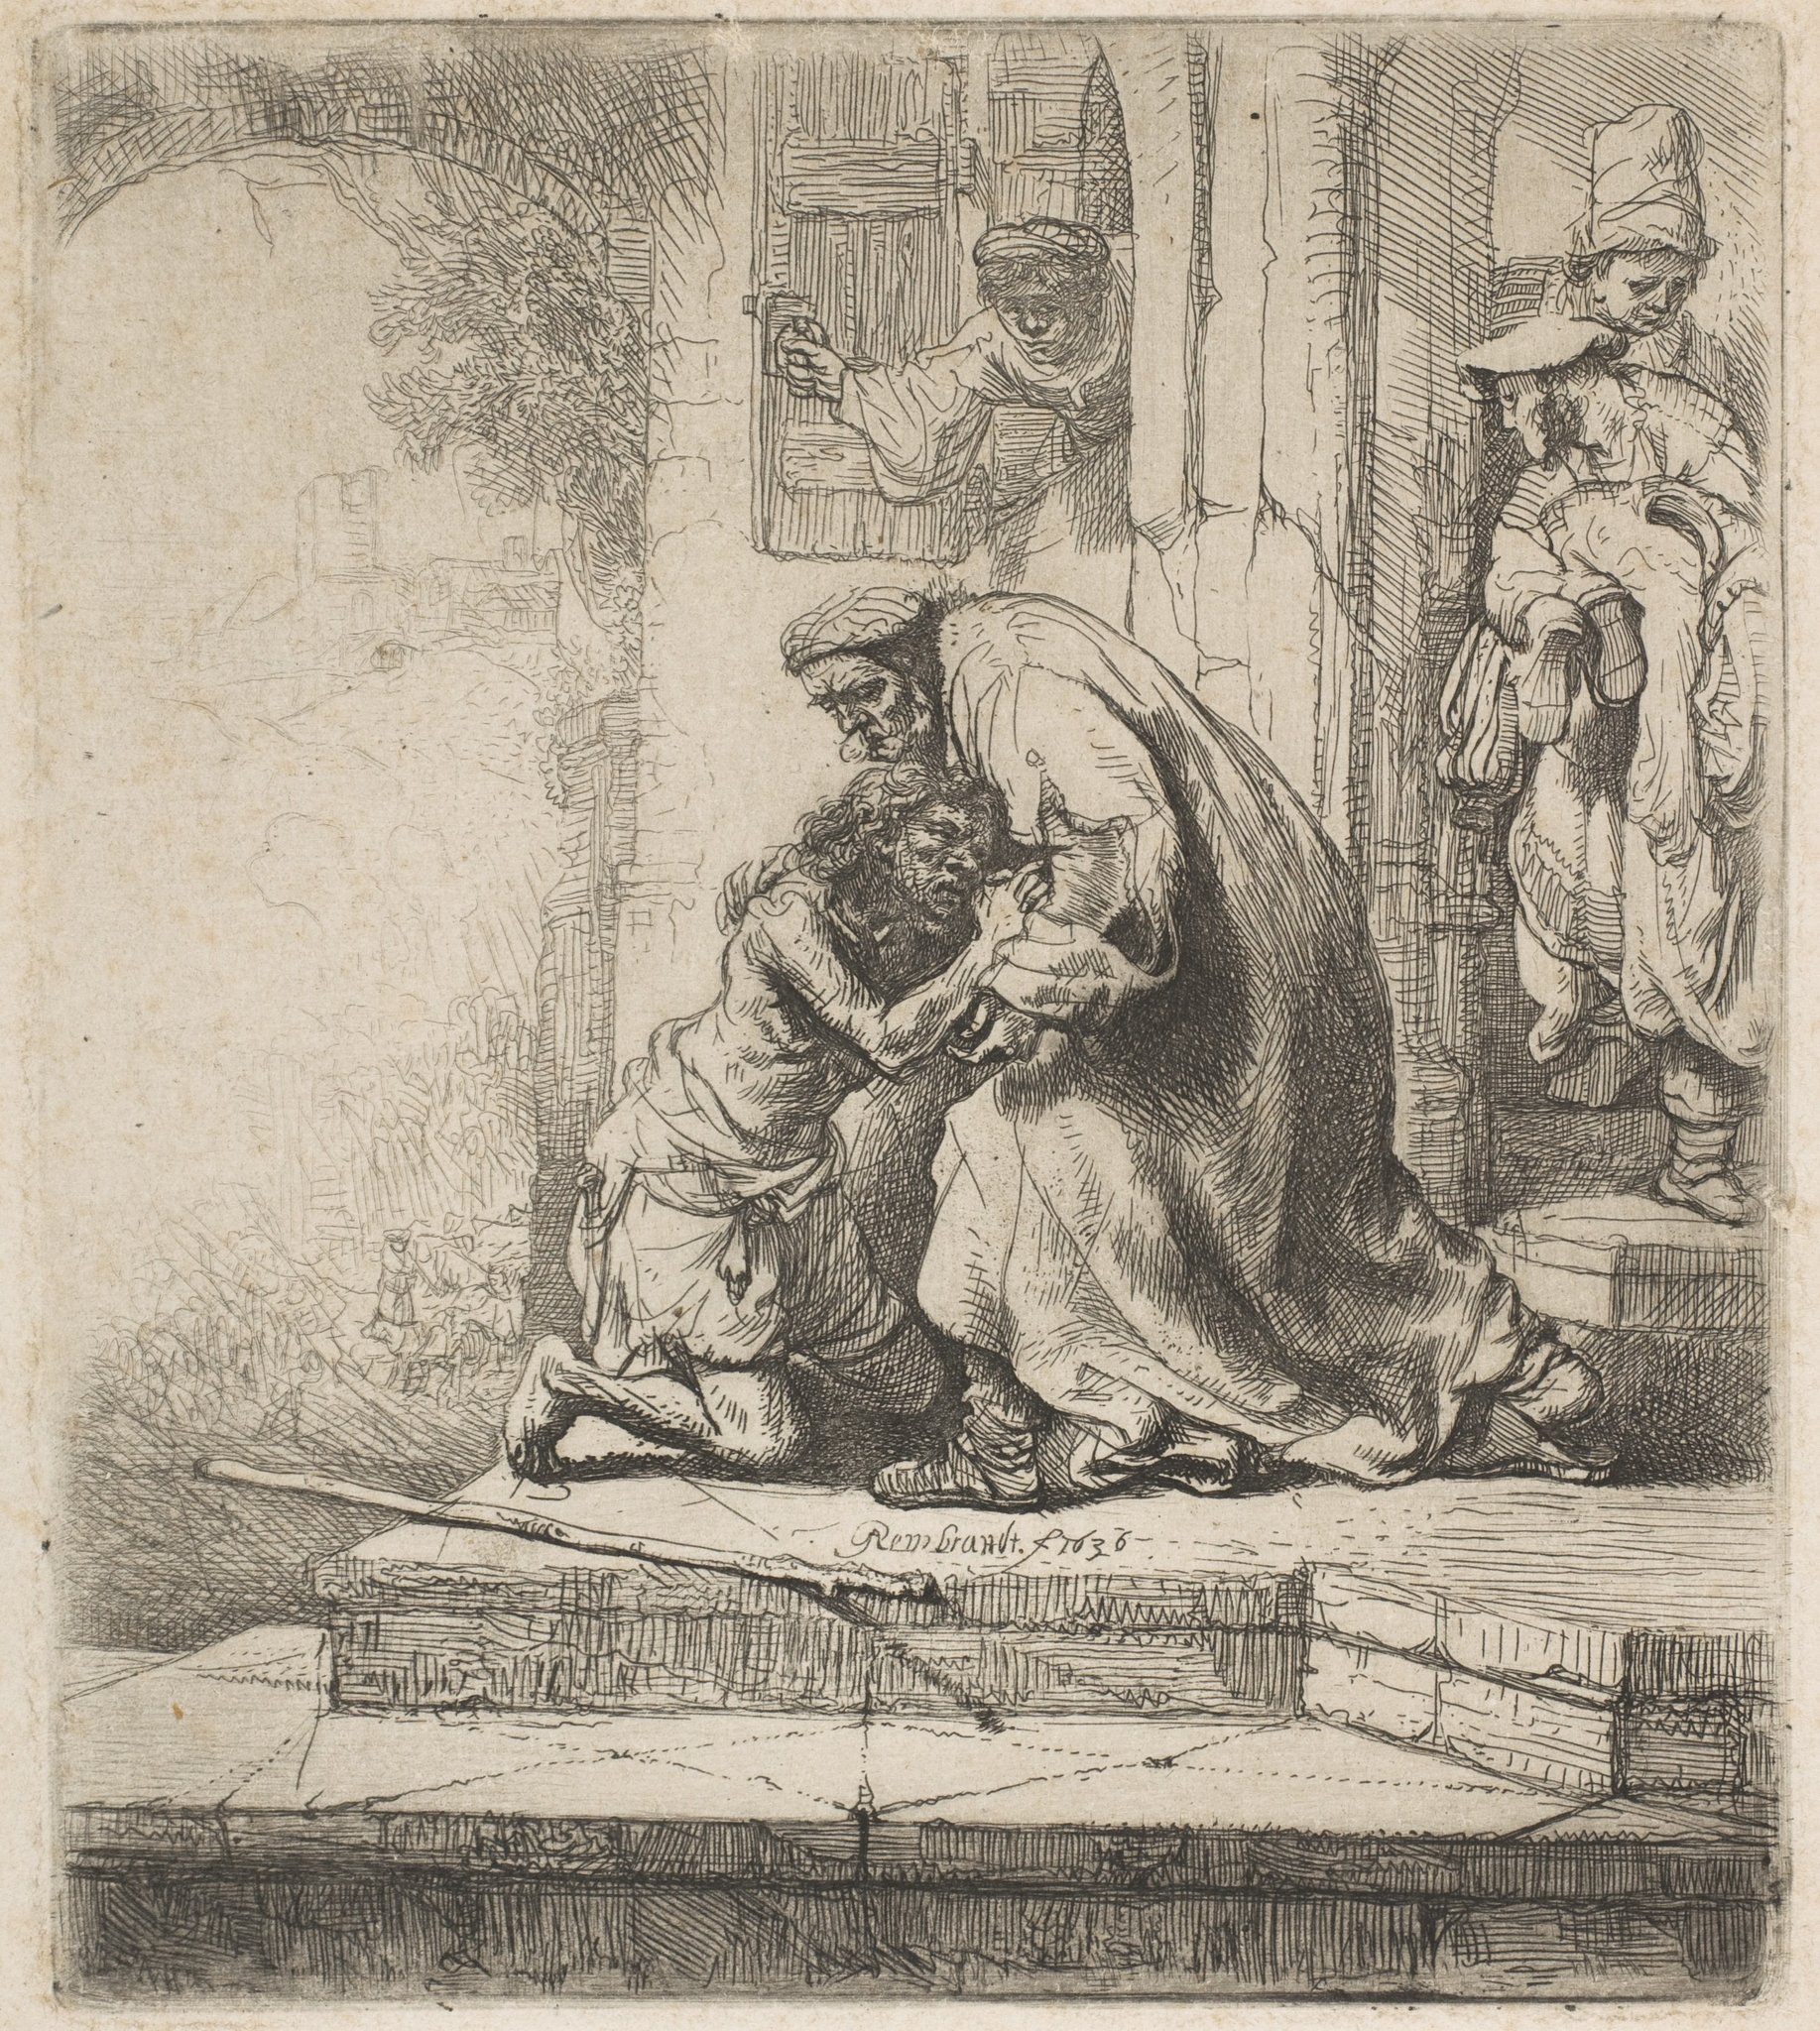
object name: print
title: The Return of the Prodigal Son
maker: rembrandt van rijn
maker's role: artist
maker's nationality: dutch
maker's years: 1606-1669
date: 1636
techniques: etching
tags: men,women,jesus